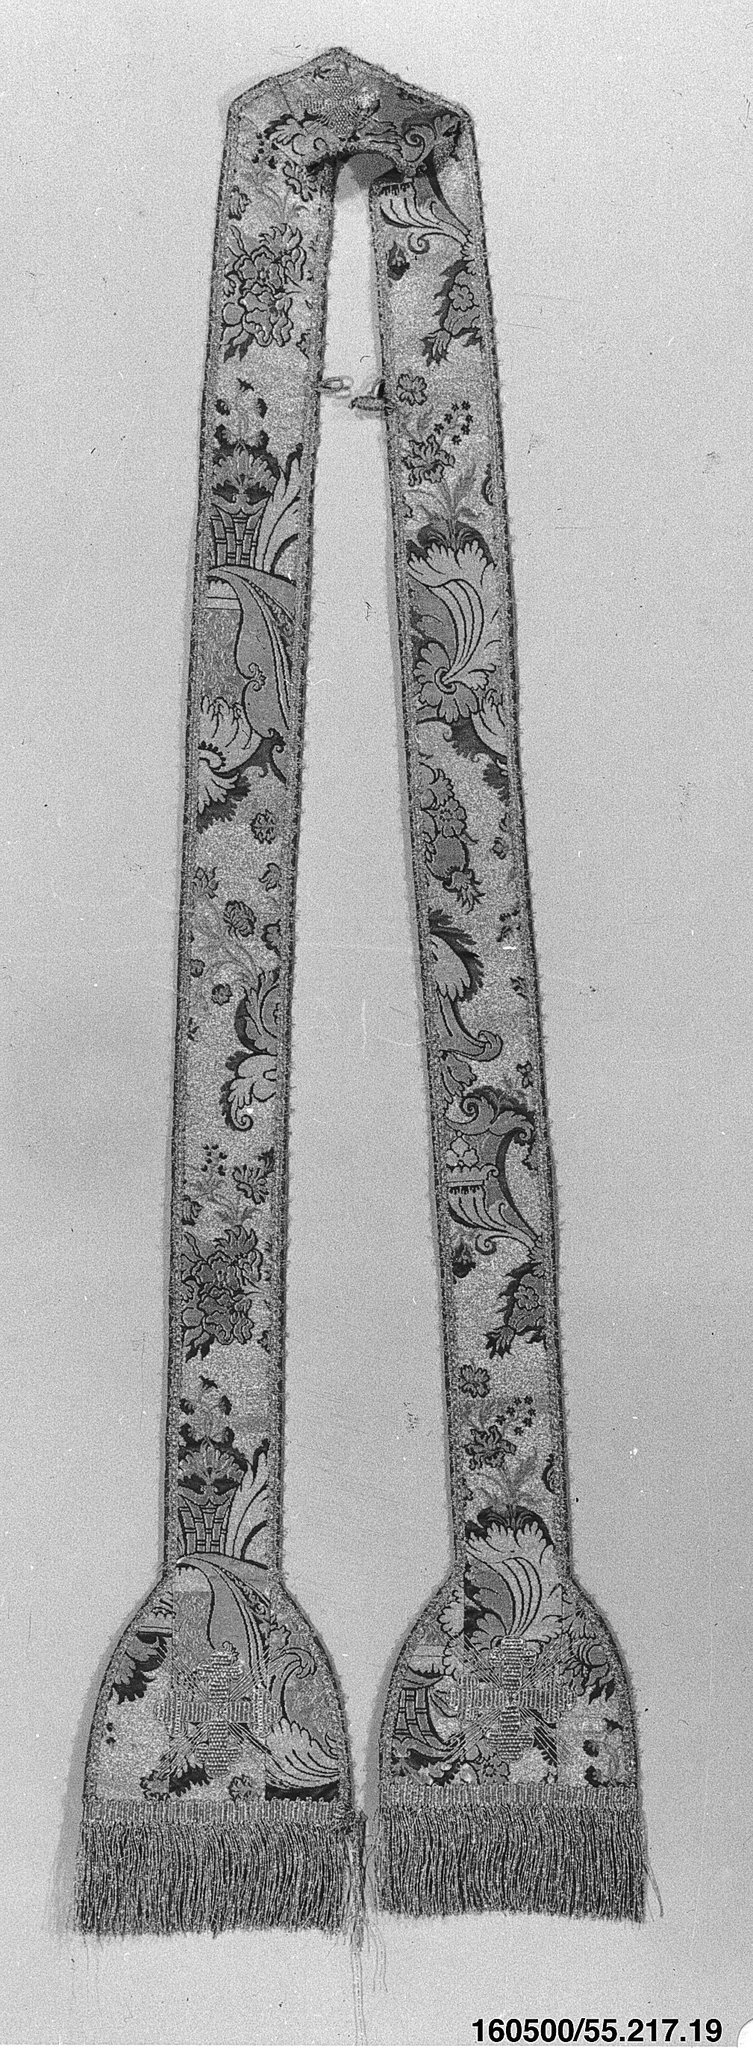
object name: stole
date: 1720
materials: metal thread, silk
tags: flowers